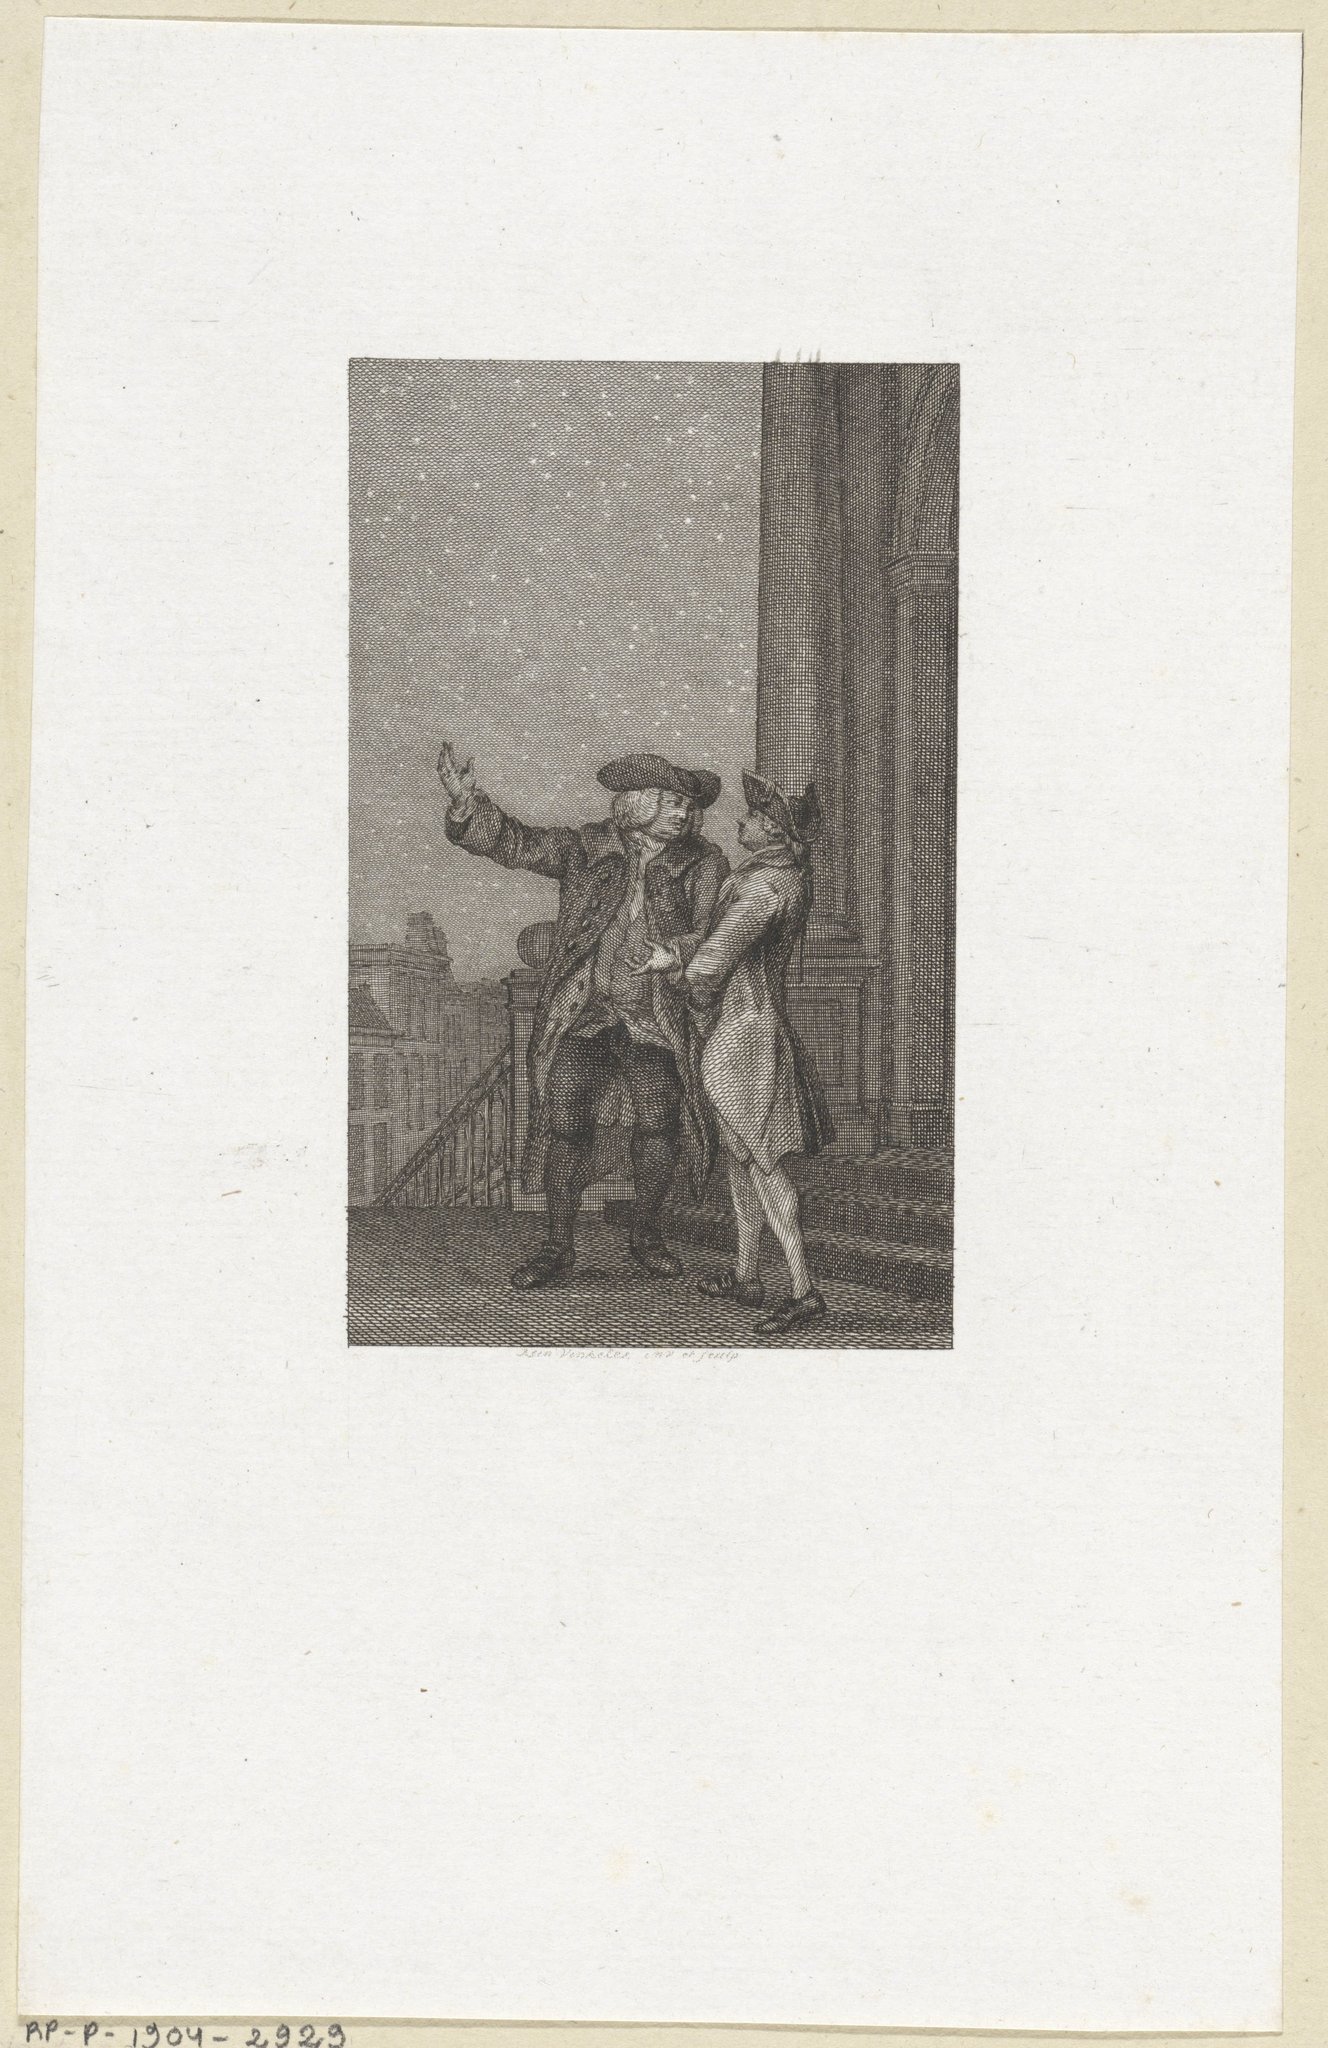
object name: print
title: Twee mannen voor een kerk in gesprek onder de sterrenhemel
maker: reinier vinkeles (i)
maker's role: draughtsman, print maker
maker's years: 1741-1816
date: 1751-1816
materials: paper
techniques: engraving, etching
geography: amsterdam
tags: church (exterior), stars, conversation, dialogue; conversation piece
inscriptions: collector's mark: Lugt 2228